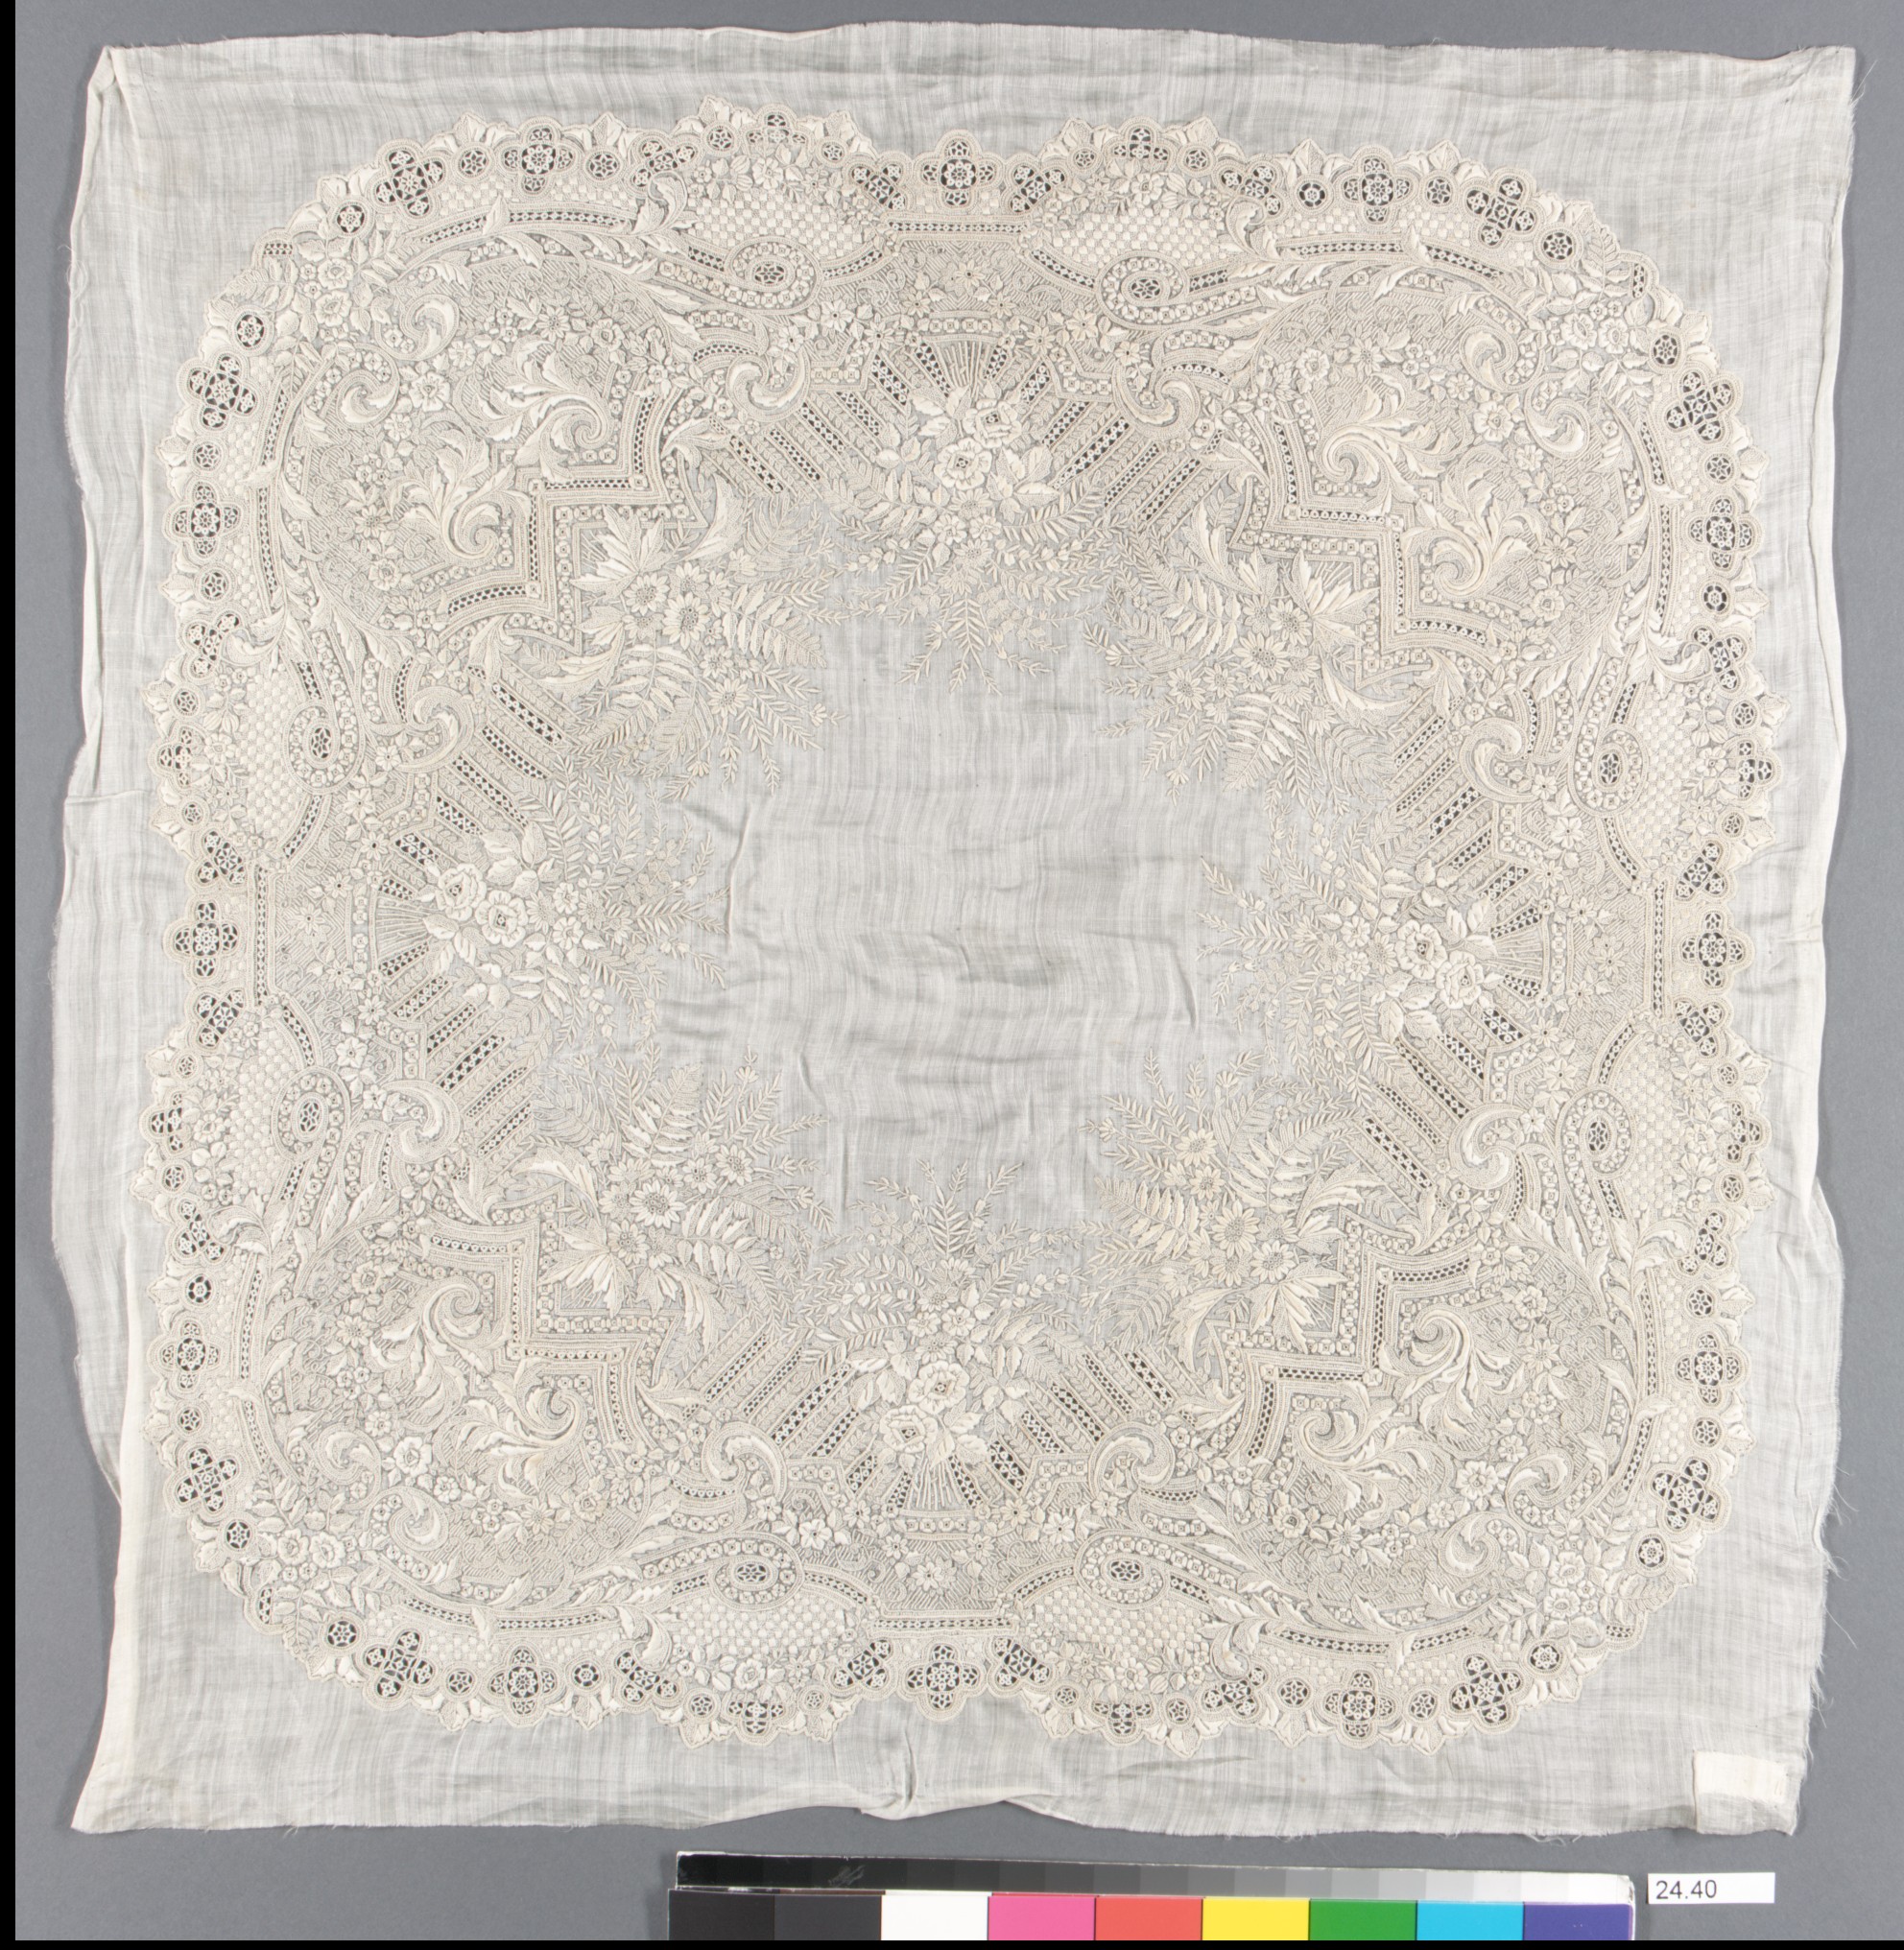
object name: handkerchief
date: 1834-1866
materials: linen, silk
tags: flowers